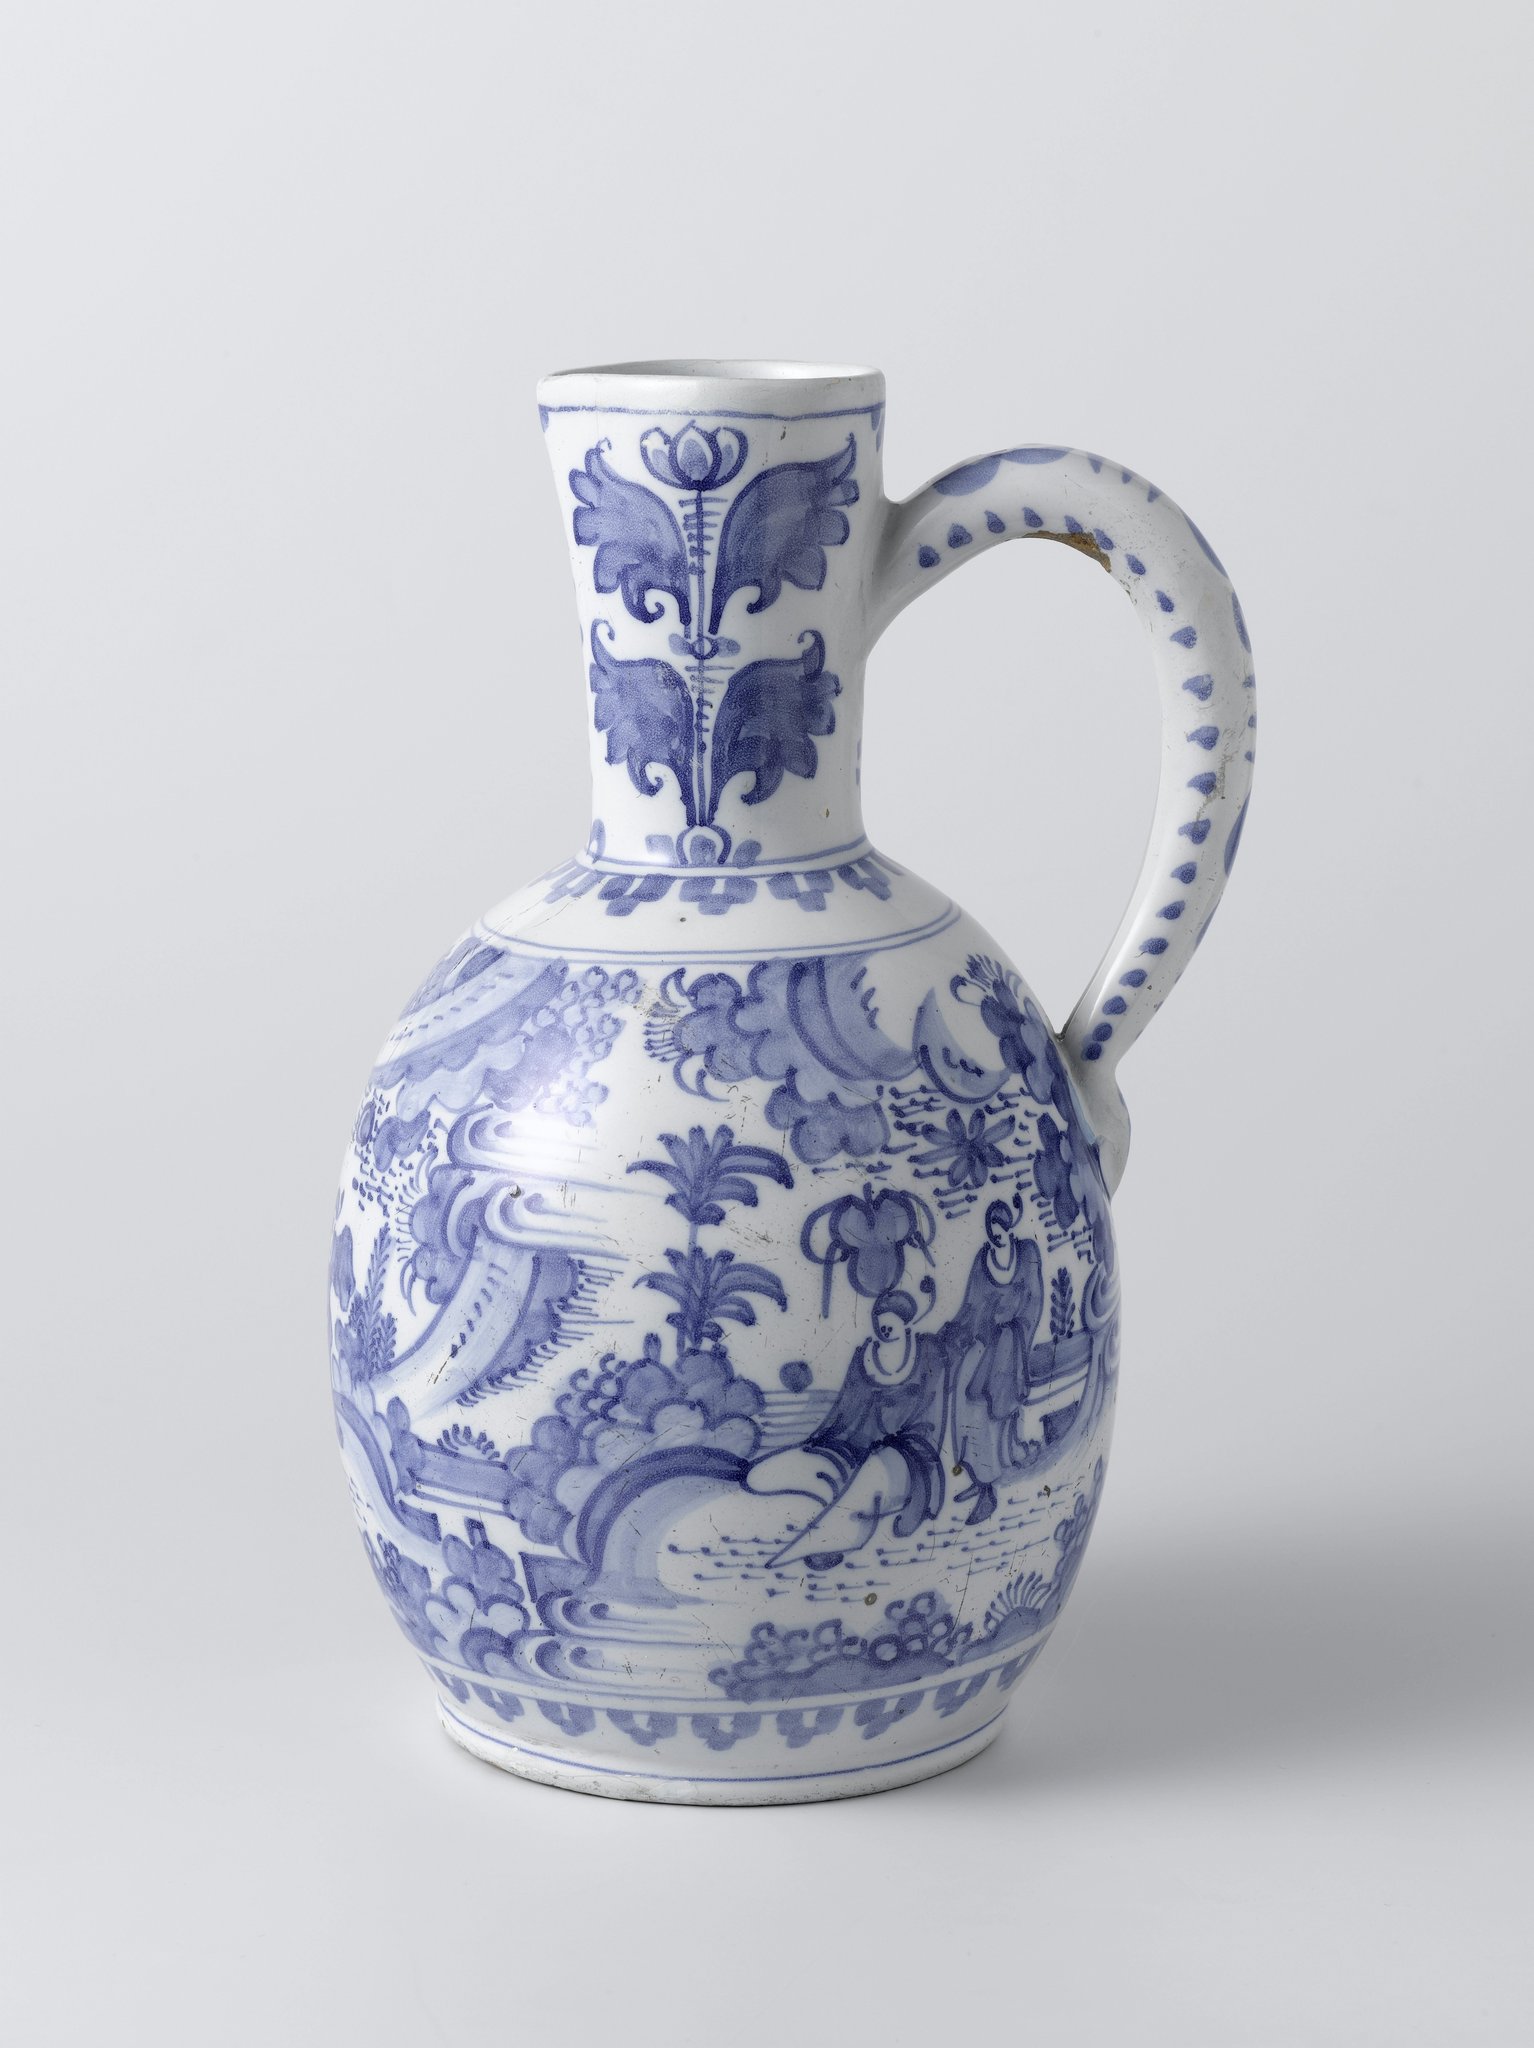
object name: ewer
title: Kan van faience met één oor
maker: Anonymous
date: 1650-1675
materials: earthenware, glaze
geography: delft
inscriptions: mark: ‘6’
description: Kan van faience met een decoratie naar het Chinese porselein uit de overgangsperiode